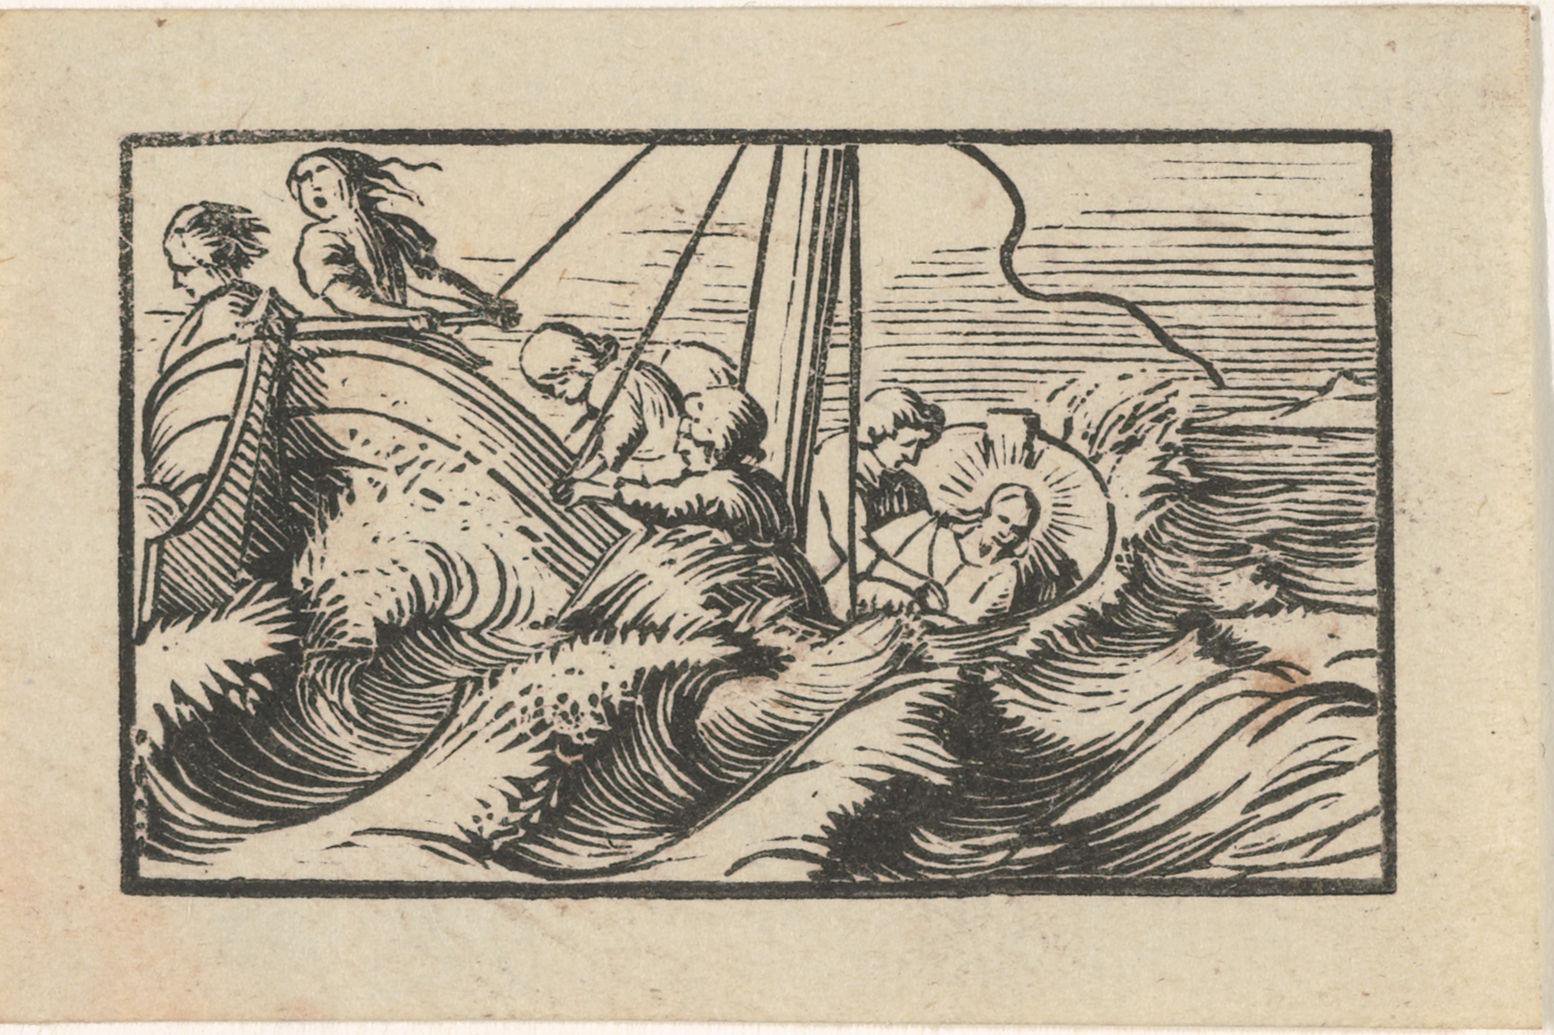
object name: print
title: Voorstellingen uit het Nieuwe Testament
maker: dirck de bray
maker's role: draughtsman, painter, print maker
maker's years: 1625-1694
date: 1635-1694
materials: paper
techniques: woodcut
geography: netherlands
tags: the apostles awake christ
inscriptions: collector's mark: Lugt 240